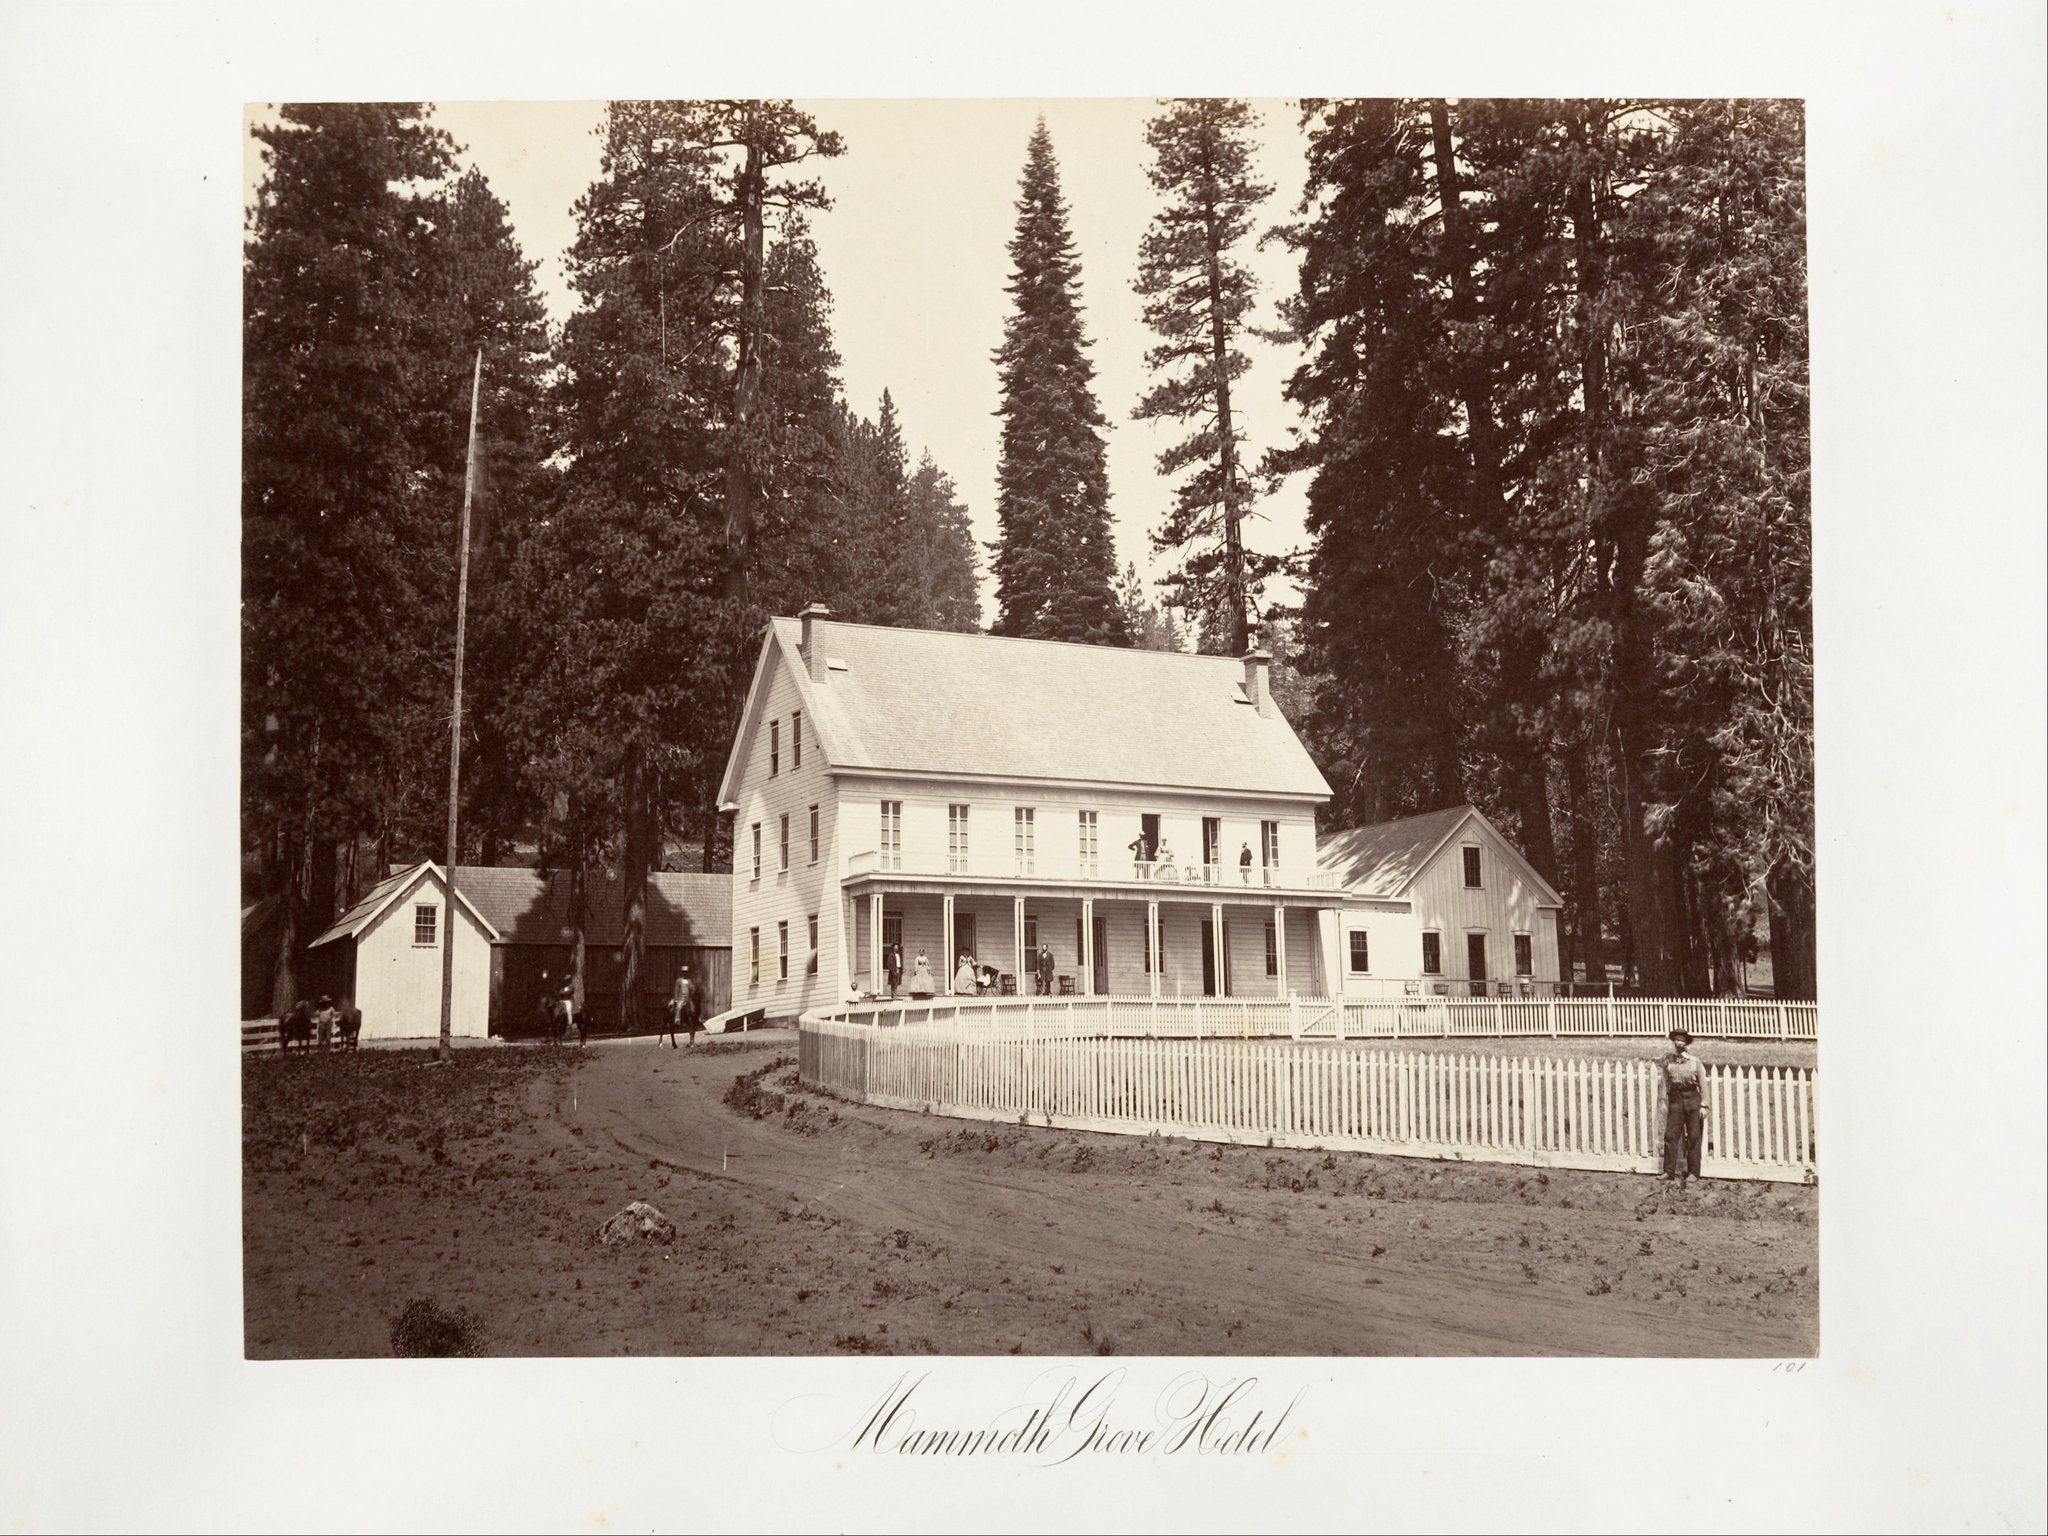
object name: photograph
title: Mammoth Grove Hotel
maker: carleton e. watkins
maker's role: artist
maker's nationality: american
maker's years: 1829-1916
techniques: albumen silver print, glass negative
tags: hotels